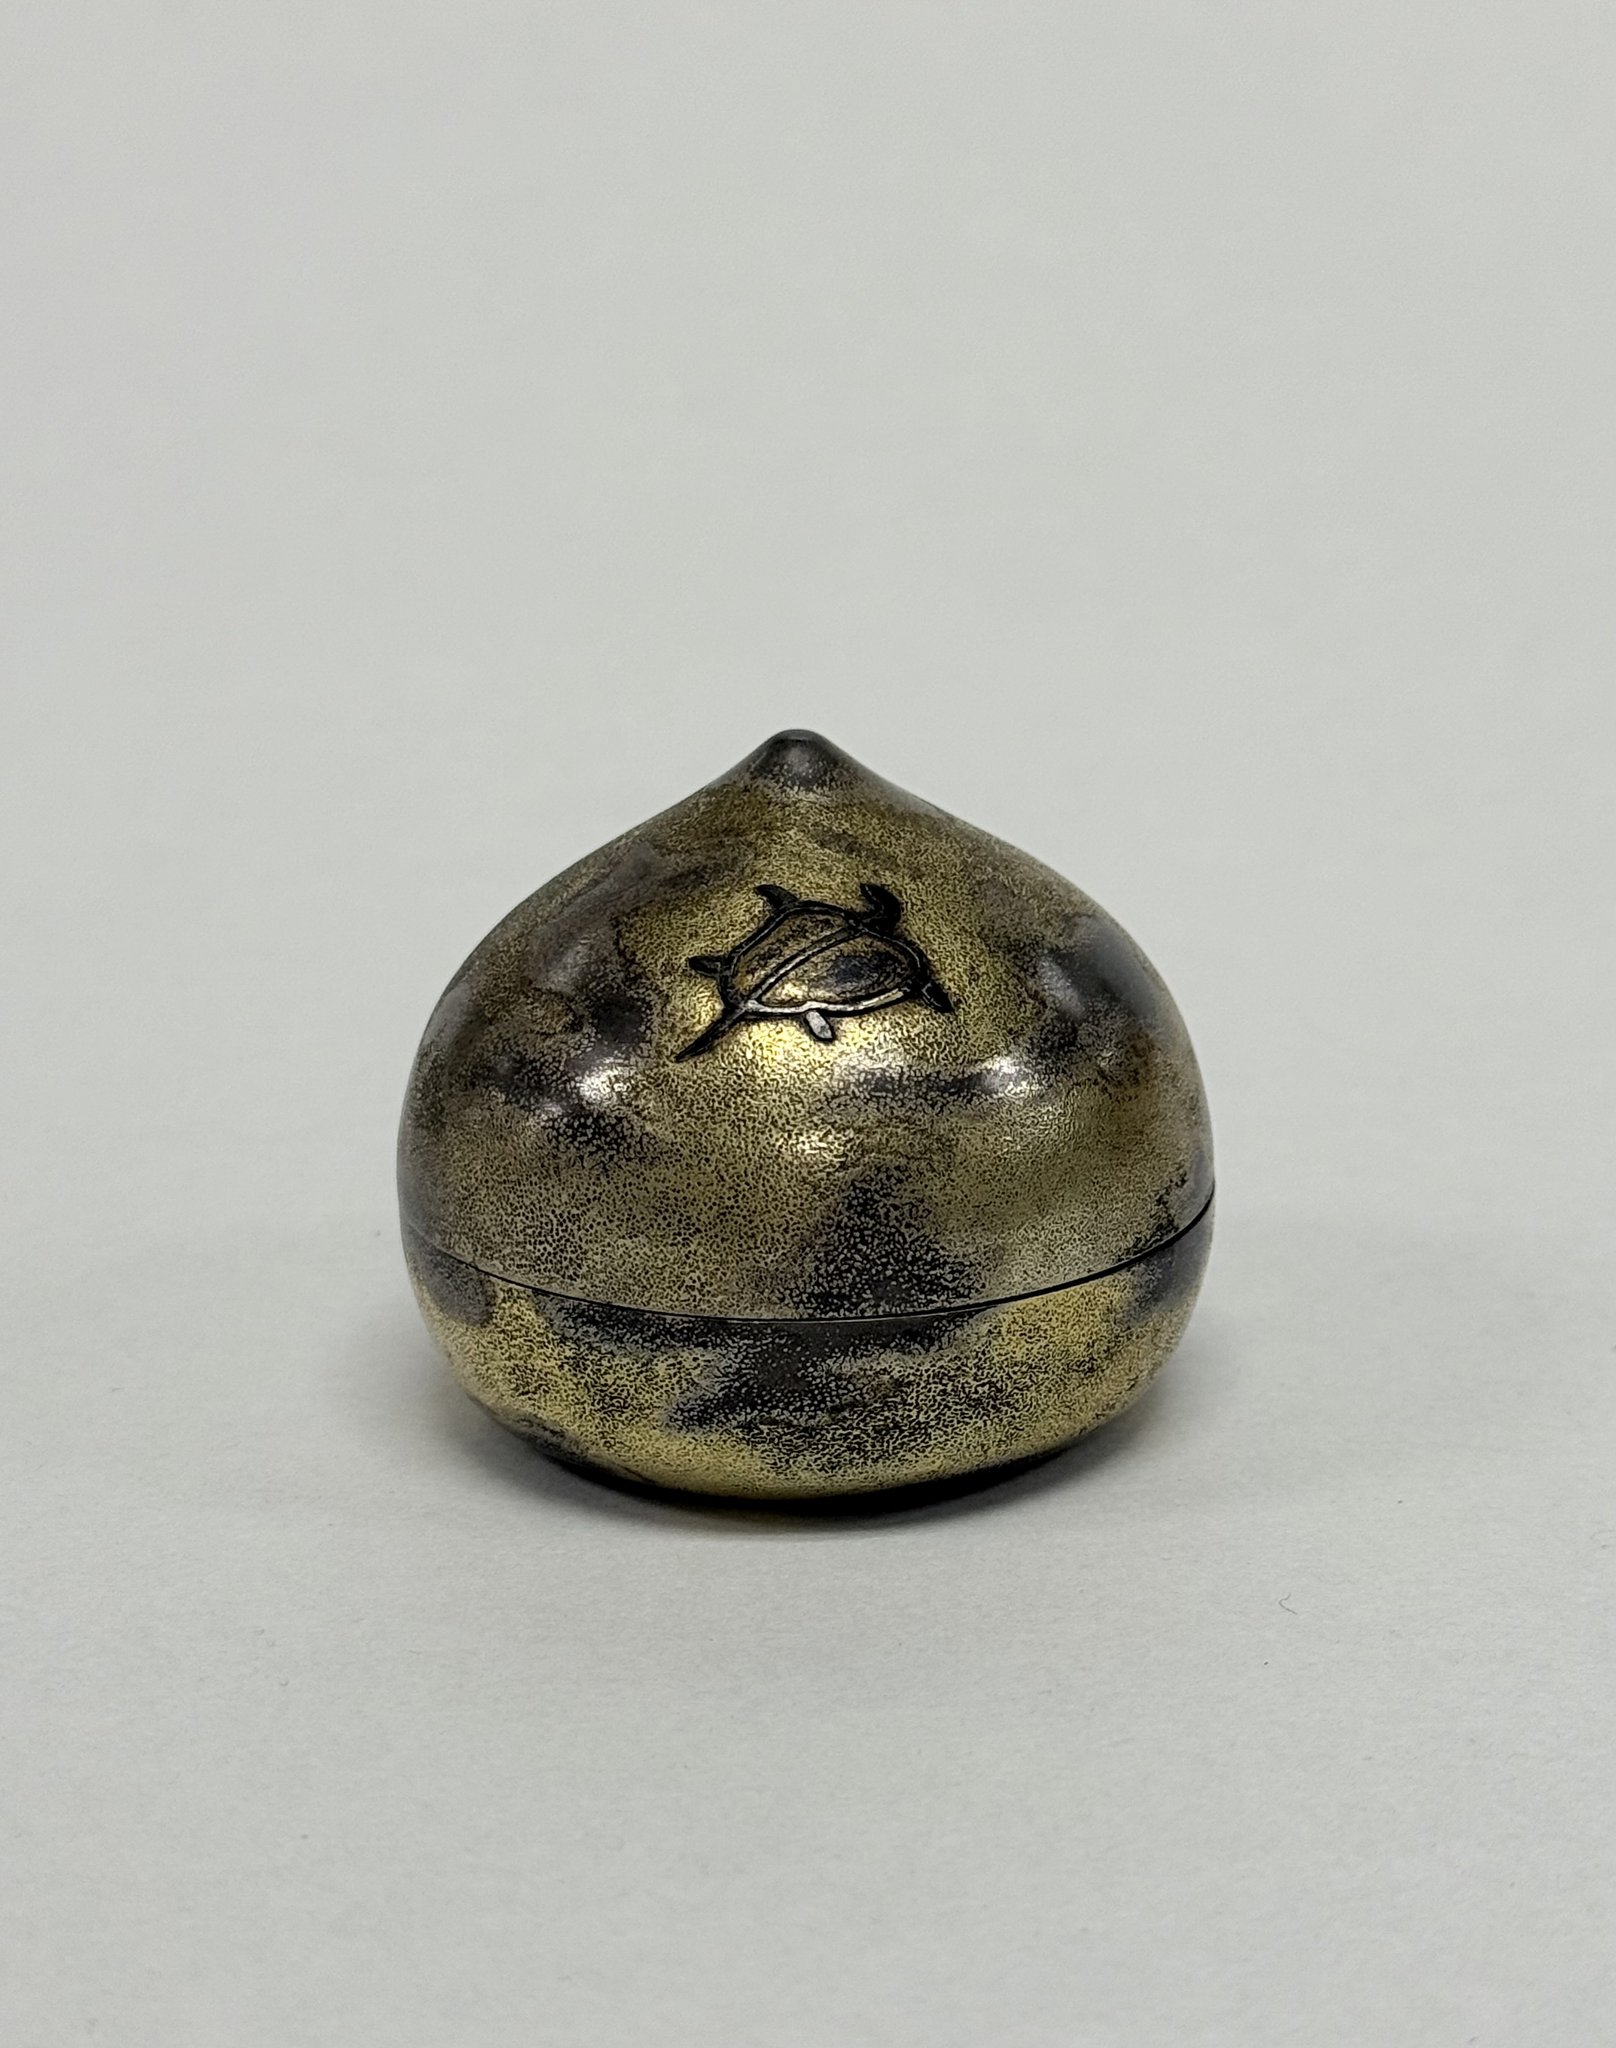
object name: incense box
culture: japanese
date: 1701-1800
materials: bronze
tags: turtles